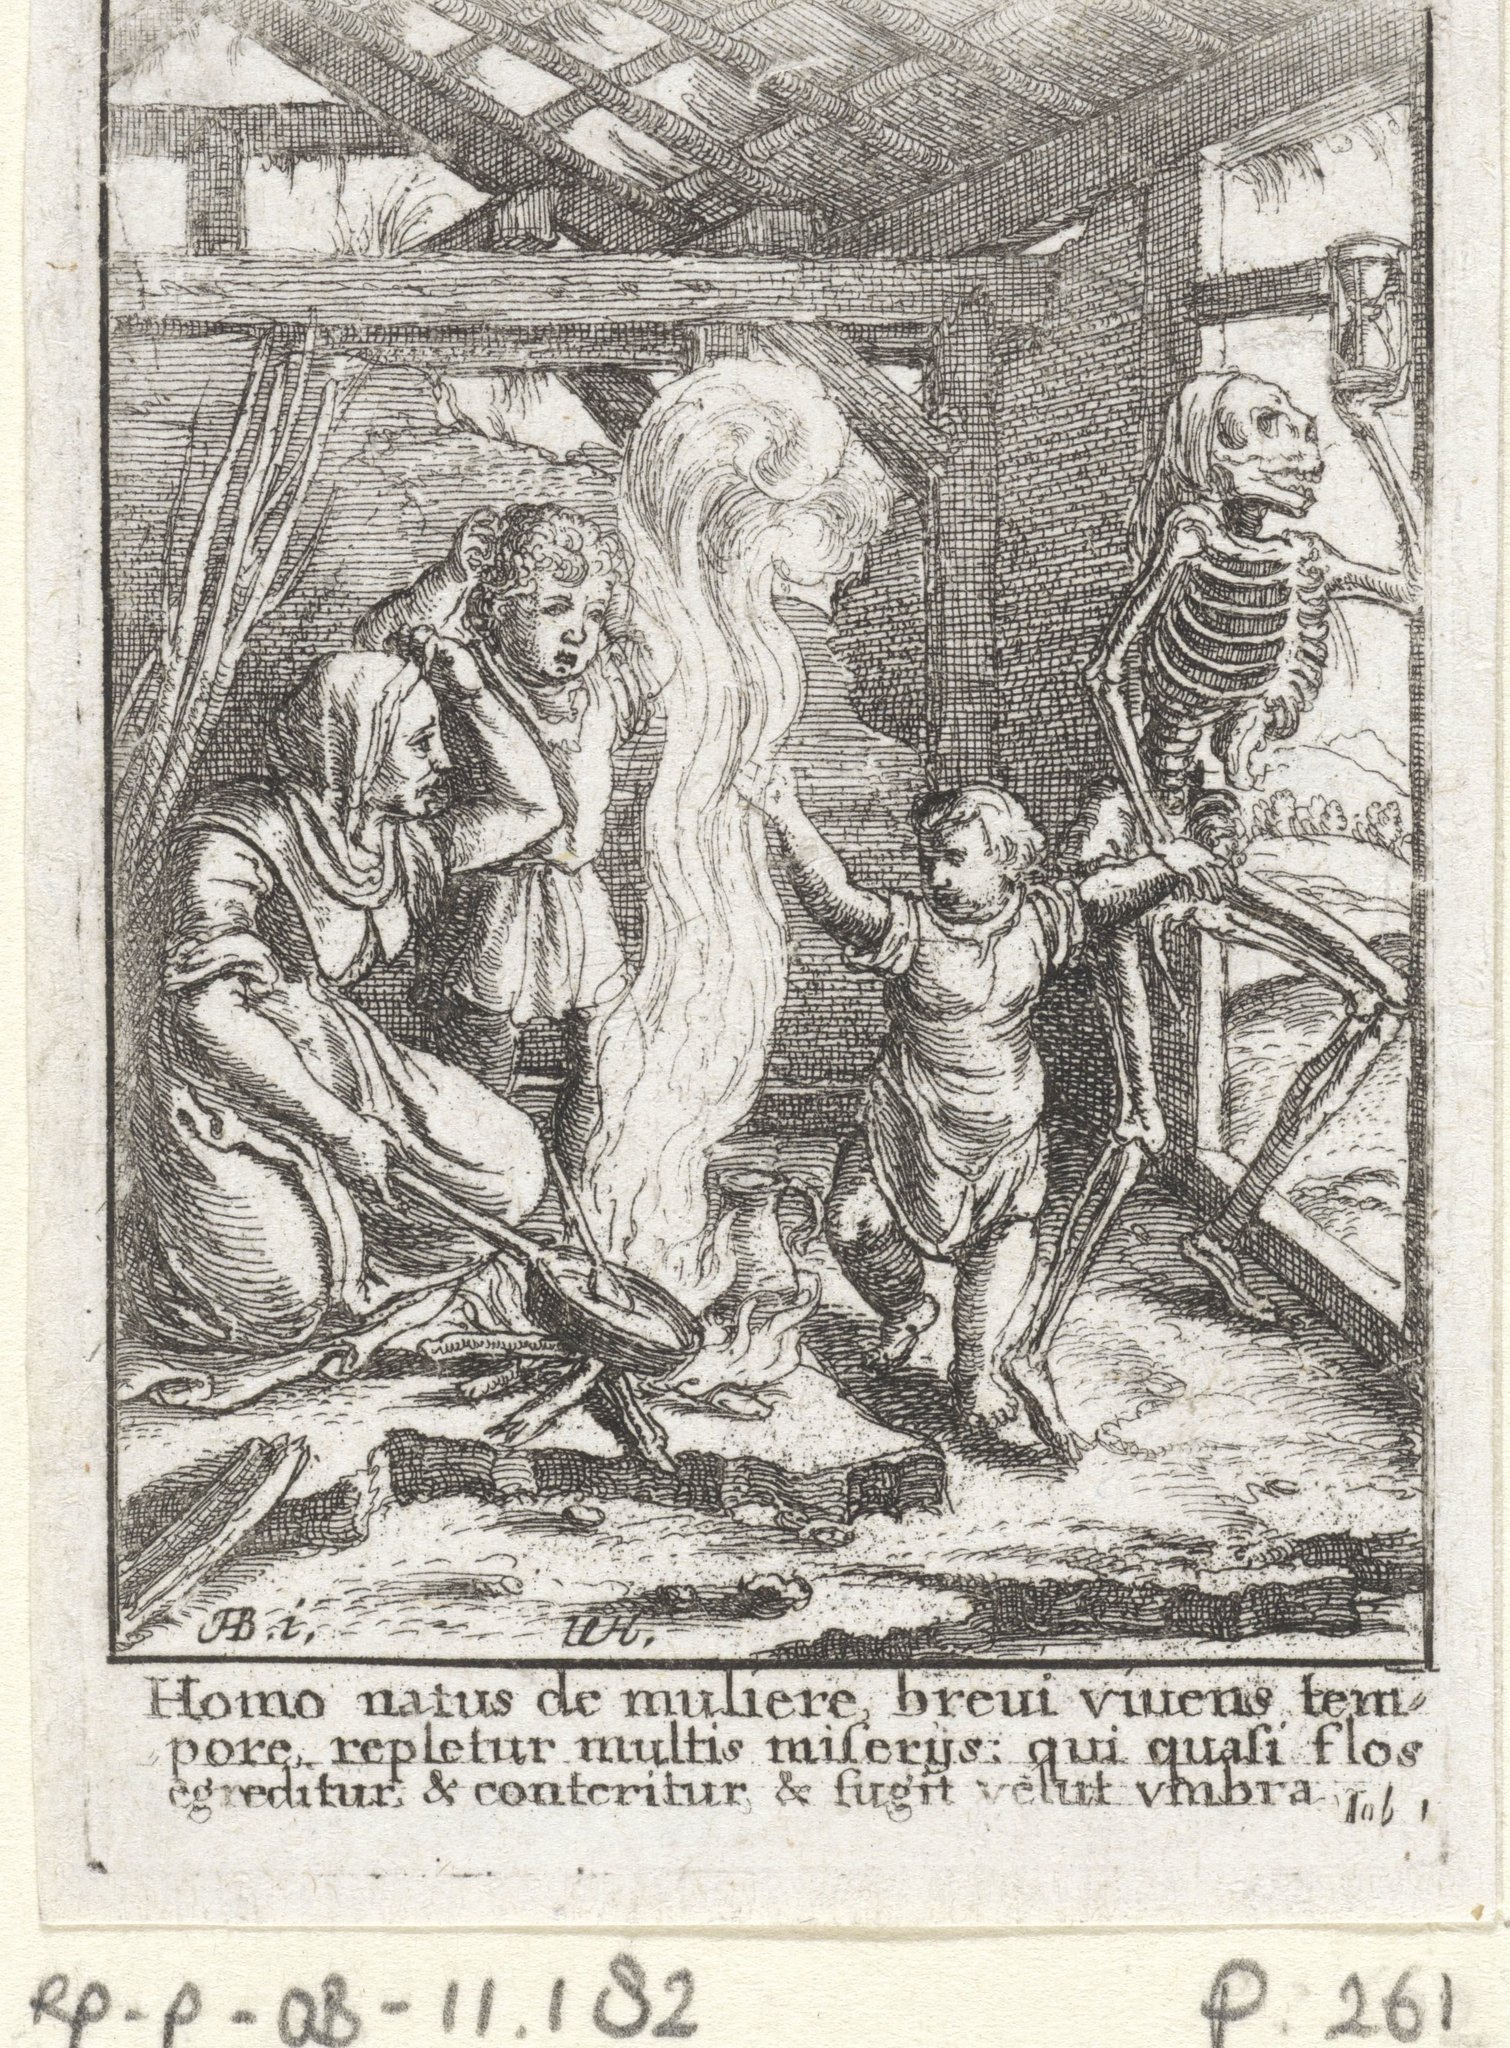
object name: book illustration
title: Dodendans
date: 1680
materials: paper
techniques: etching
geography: antwerp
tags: dance of death; death together with one or more human beings, death of a child, hourglass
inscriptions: collector's mark: Lugt 240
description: Een kind dat met zijn ouders rond een vuur in hun huis zit, wordt door de Dood meegenomen. De ouders kijken wanhopig toe terwijl de Dood met een zandloper in zijn hand het kind mee naar buiten neemt.